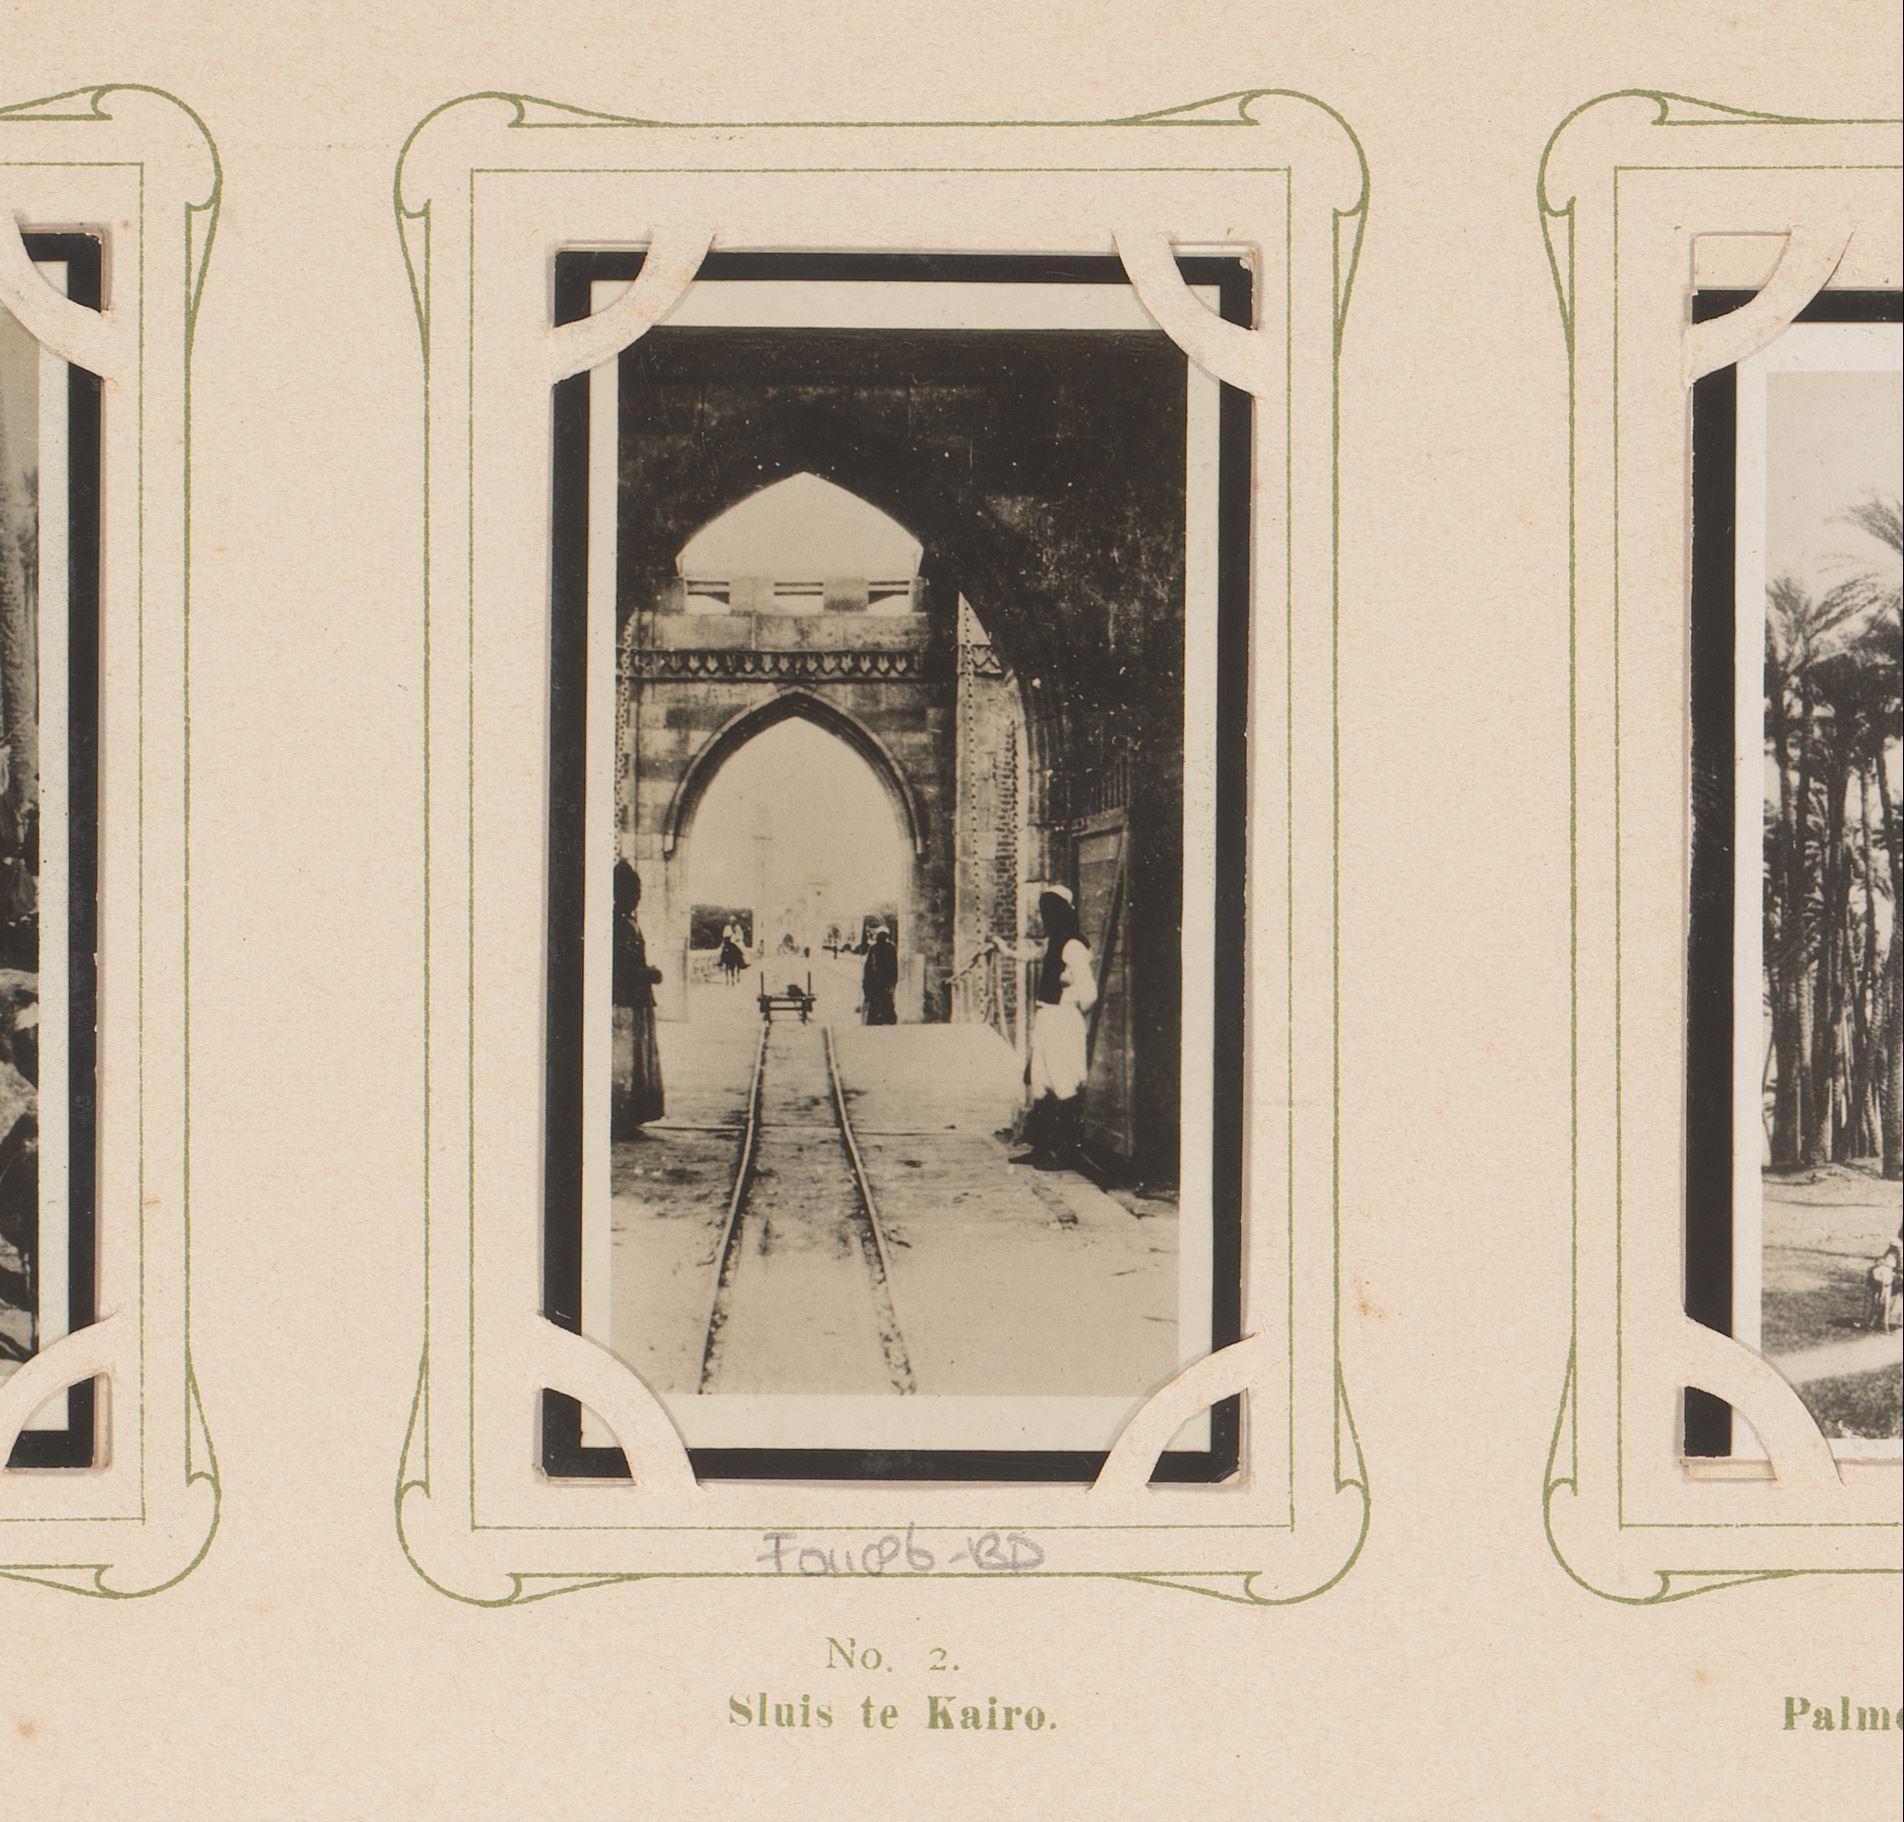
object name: album leaf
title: Gezicht op een sluis te Caïro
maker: Anonymous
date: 1904-1905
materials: photographic support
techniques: gelatin silver print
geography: cairo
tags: sluice, weir, street (+ city(-scape) with figures, staffage)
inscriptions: inscription: ‘No. 2./ Sluis te Kairo.’